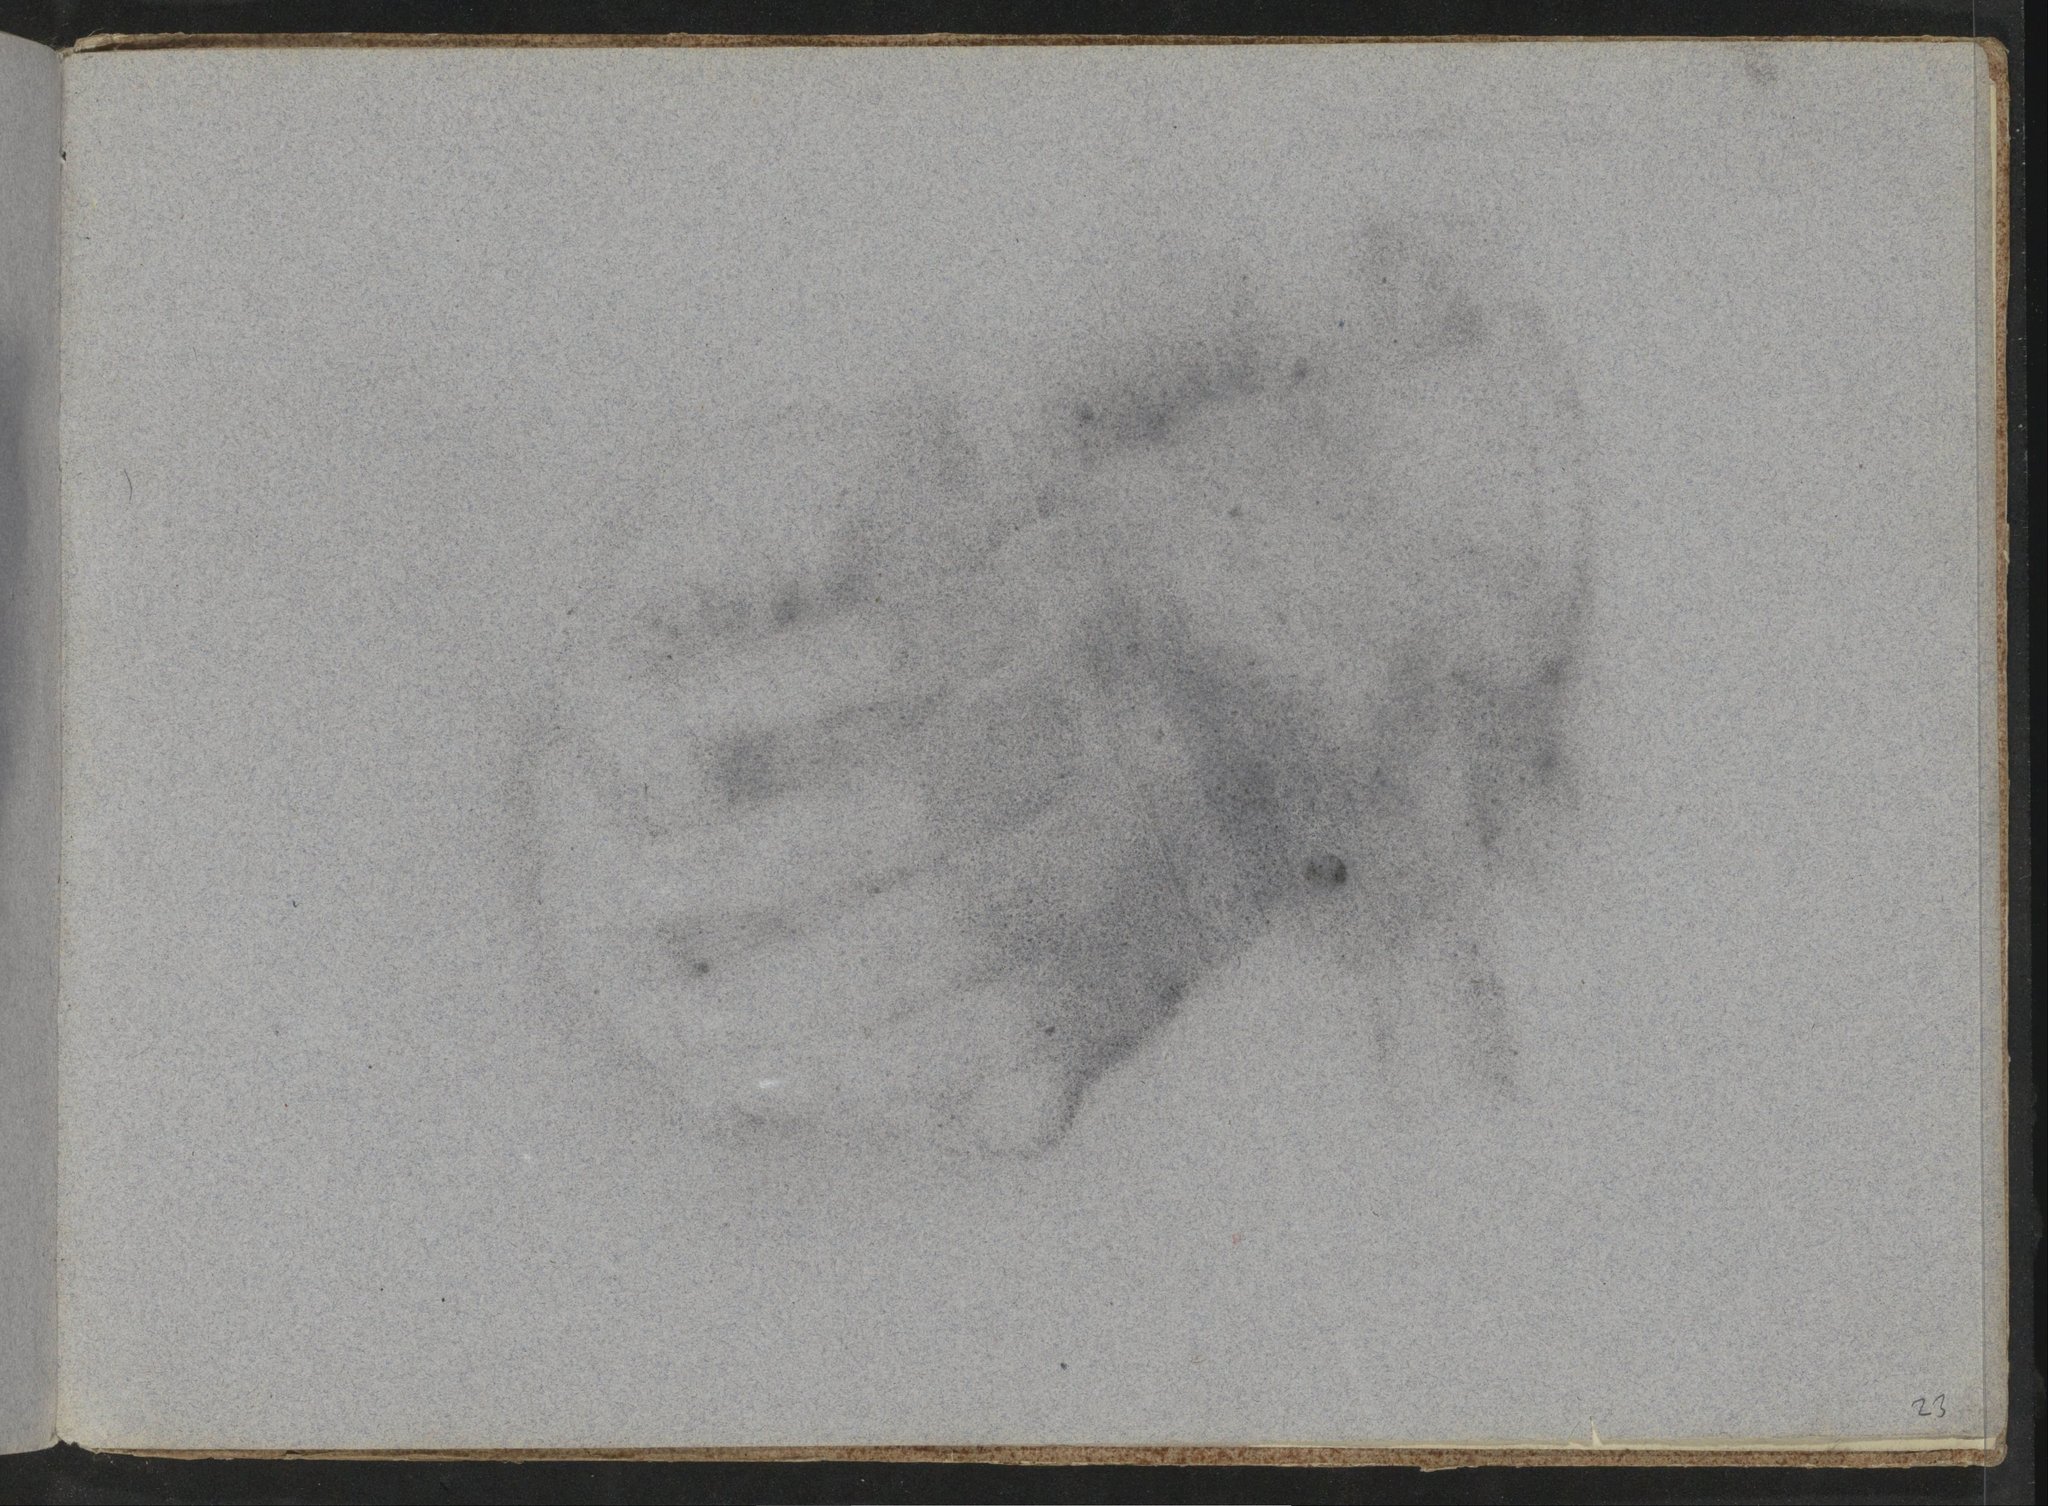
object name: sketchbook leaf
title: Abklatsch van de krijttekening op blad 22 verso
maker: s. altmann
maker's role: painter, print maker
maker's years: 1822-1890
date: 1803-1840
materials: paper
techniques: printmaking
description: Blad 23 recto uit een schetsboek met 24 bladen.